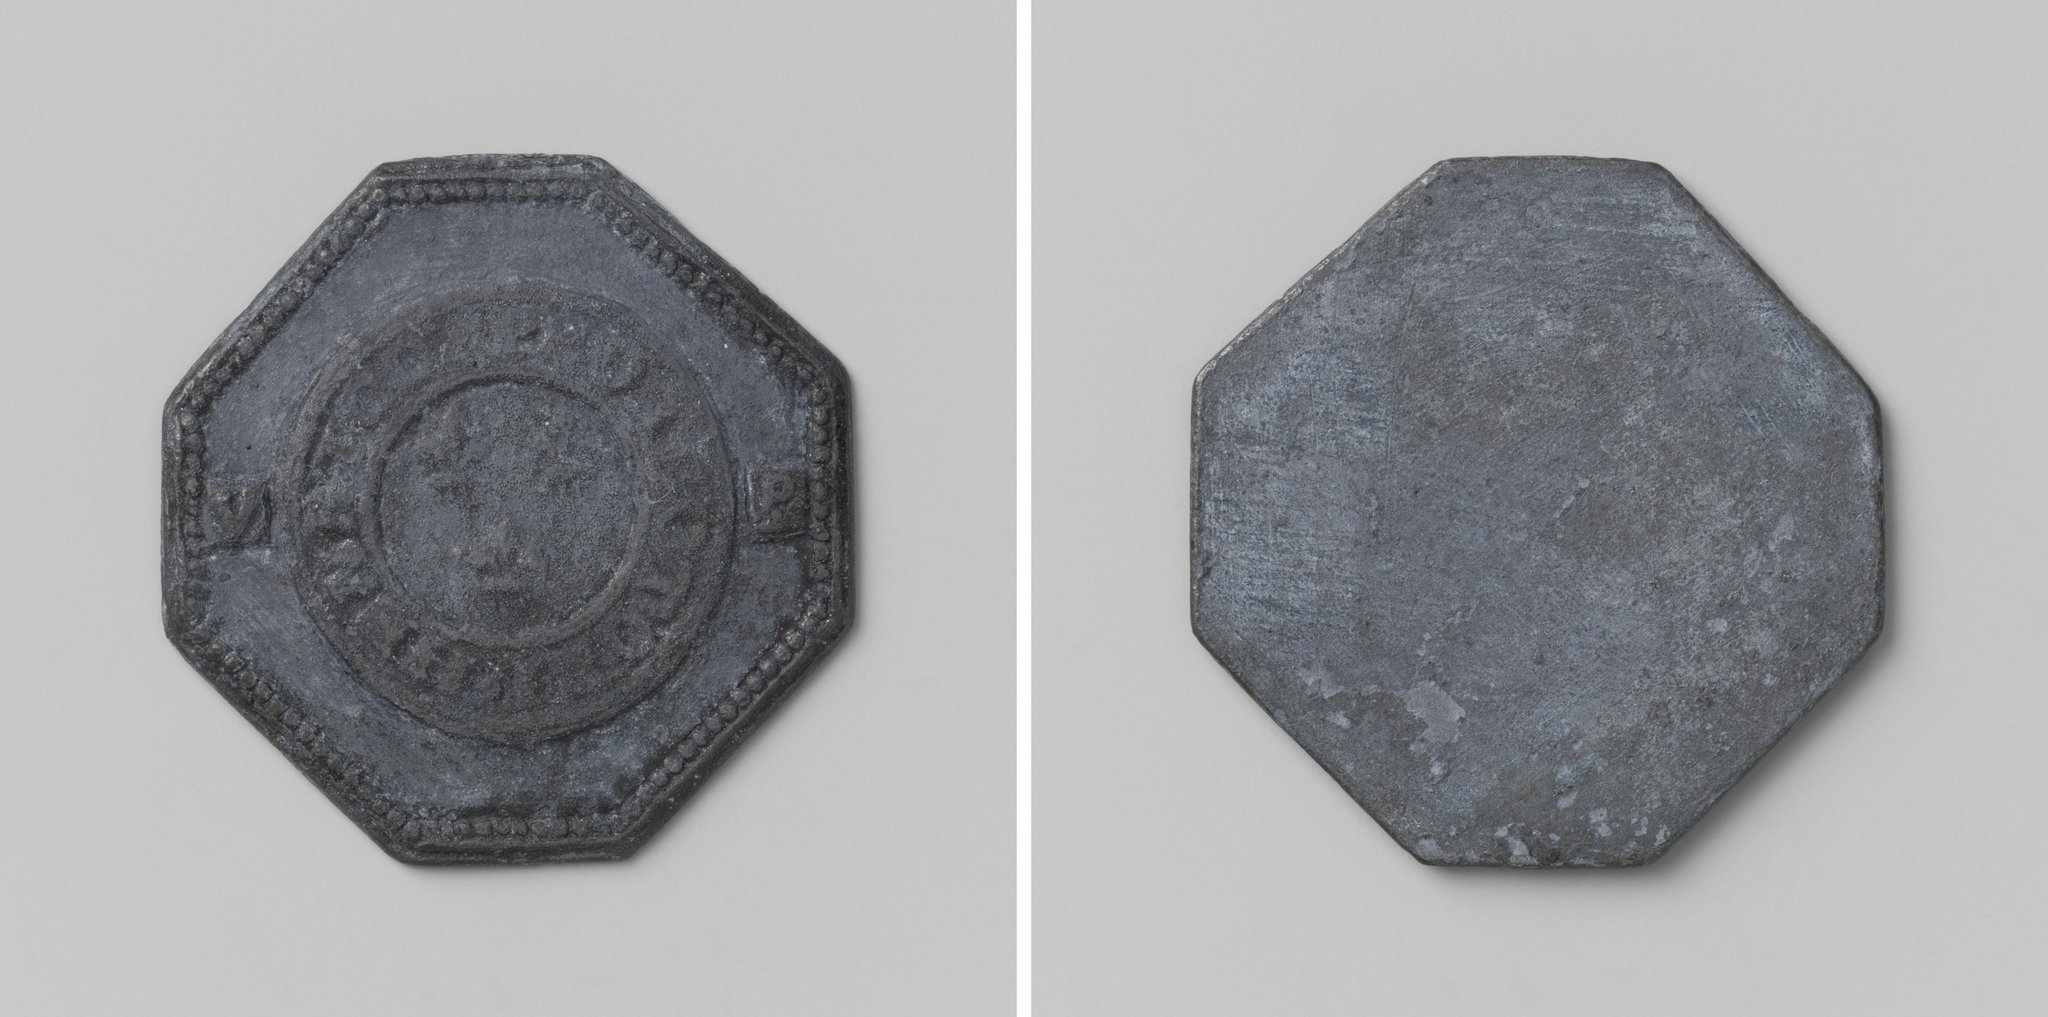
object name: coin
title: Vijf stuiver, vervalste noodmunt uit Kamerijk, geslagen tijdens het beleg door de Franse verdedigers van de stad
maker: Anonymous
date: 1589-1883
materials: lead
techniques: striking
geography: belgium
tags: paris, hendrik iv (koning van frankrijk en navarra)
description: eenzijdige, achthoekige noodmunt (vals) van Kamerijk. Voorzijde: binnen parelrand: drie stempels: in midden een grote, ronde stempel: drie lelies binnen omschrift; links en rechts: stempels met waardeaanduiding. Keerzijde: blanco